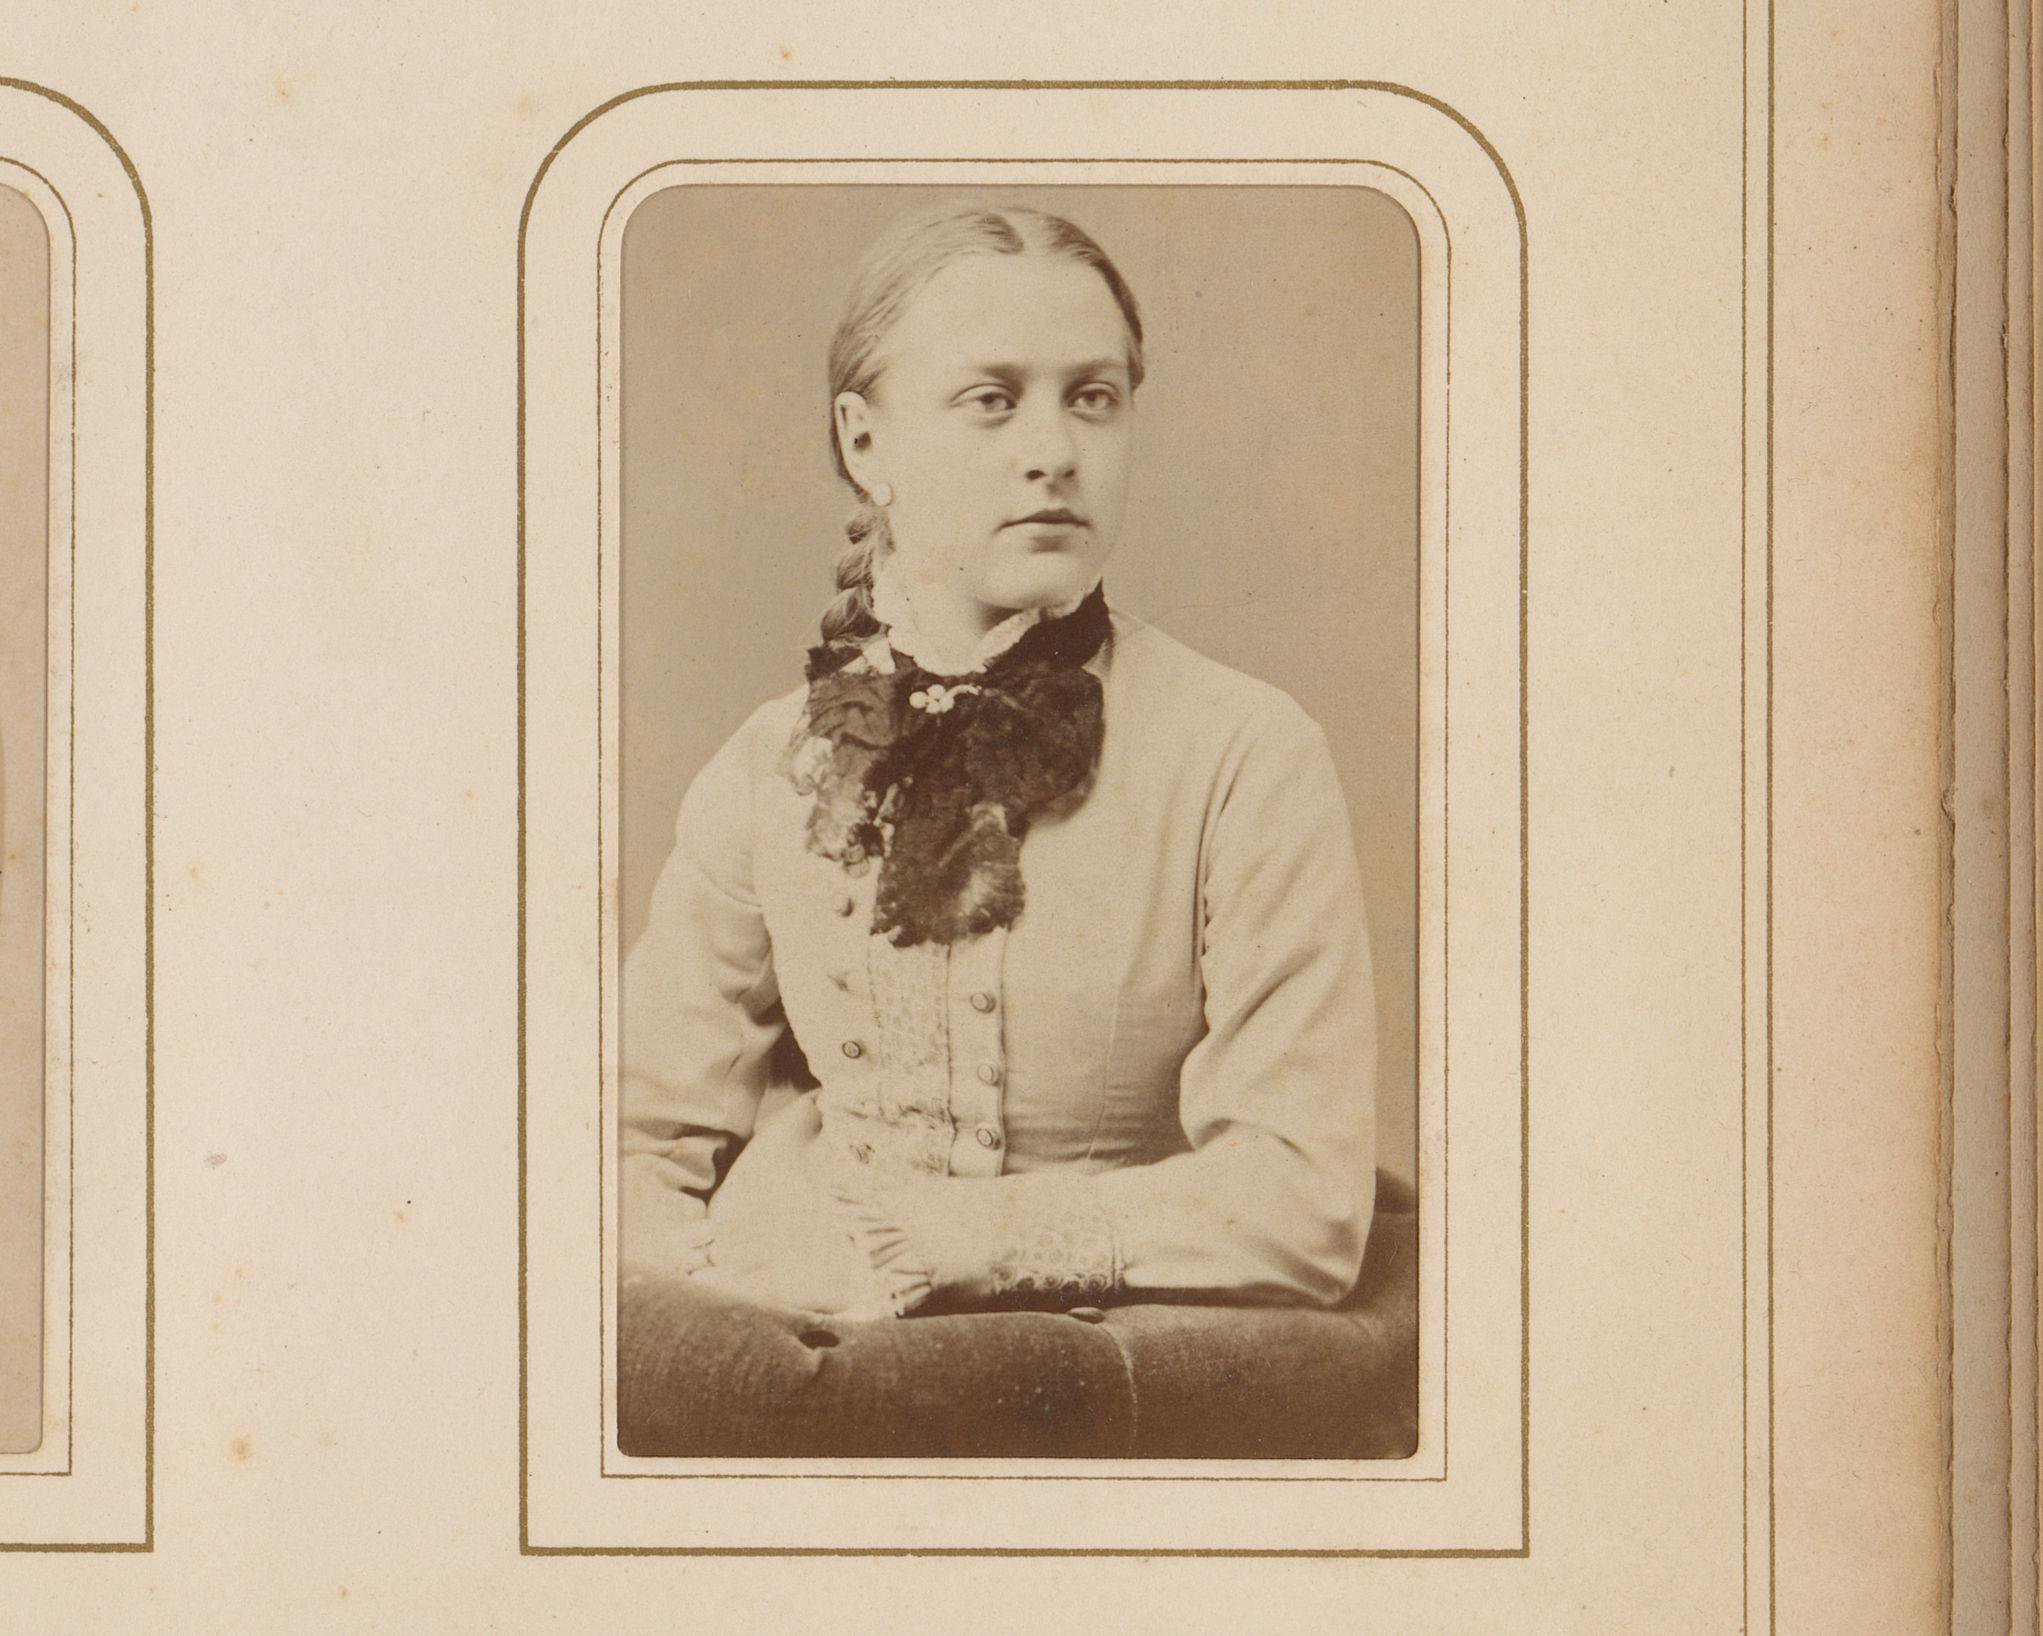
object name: carte de visite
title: Portret van een jonge vrouw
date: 1877-1884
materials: cardboard, photographic support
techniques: albumen print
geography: amsterdam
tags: adolescent, young woman, maiden, historical persons - bb - woman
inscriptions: inscription: ‘American/ PHOTOGRAPHY/ Hisgen Bros/ 128, P. C. HOOFTSTRAAT/ Amsterdam’